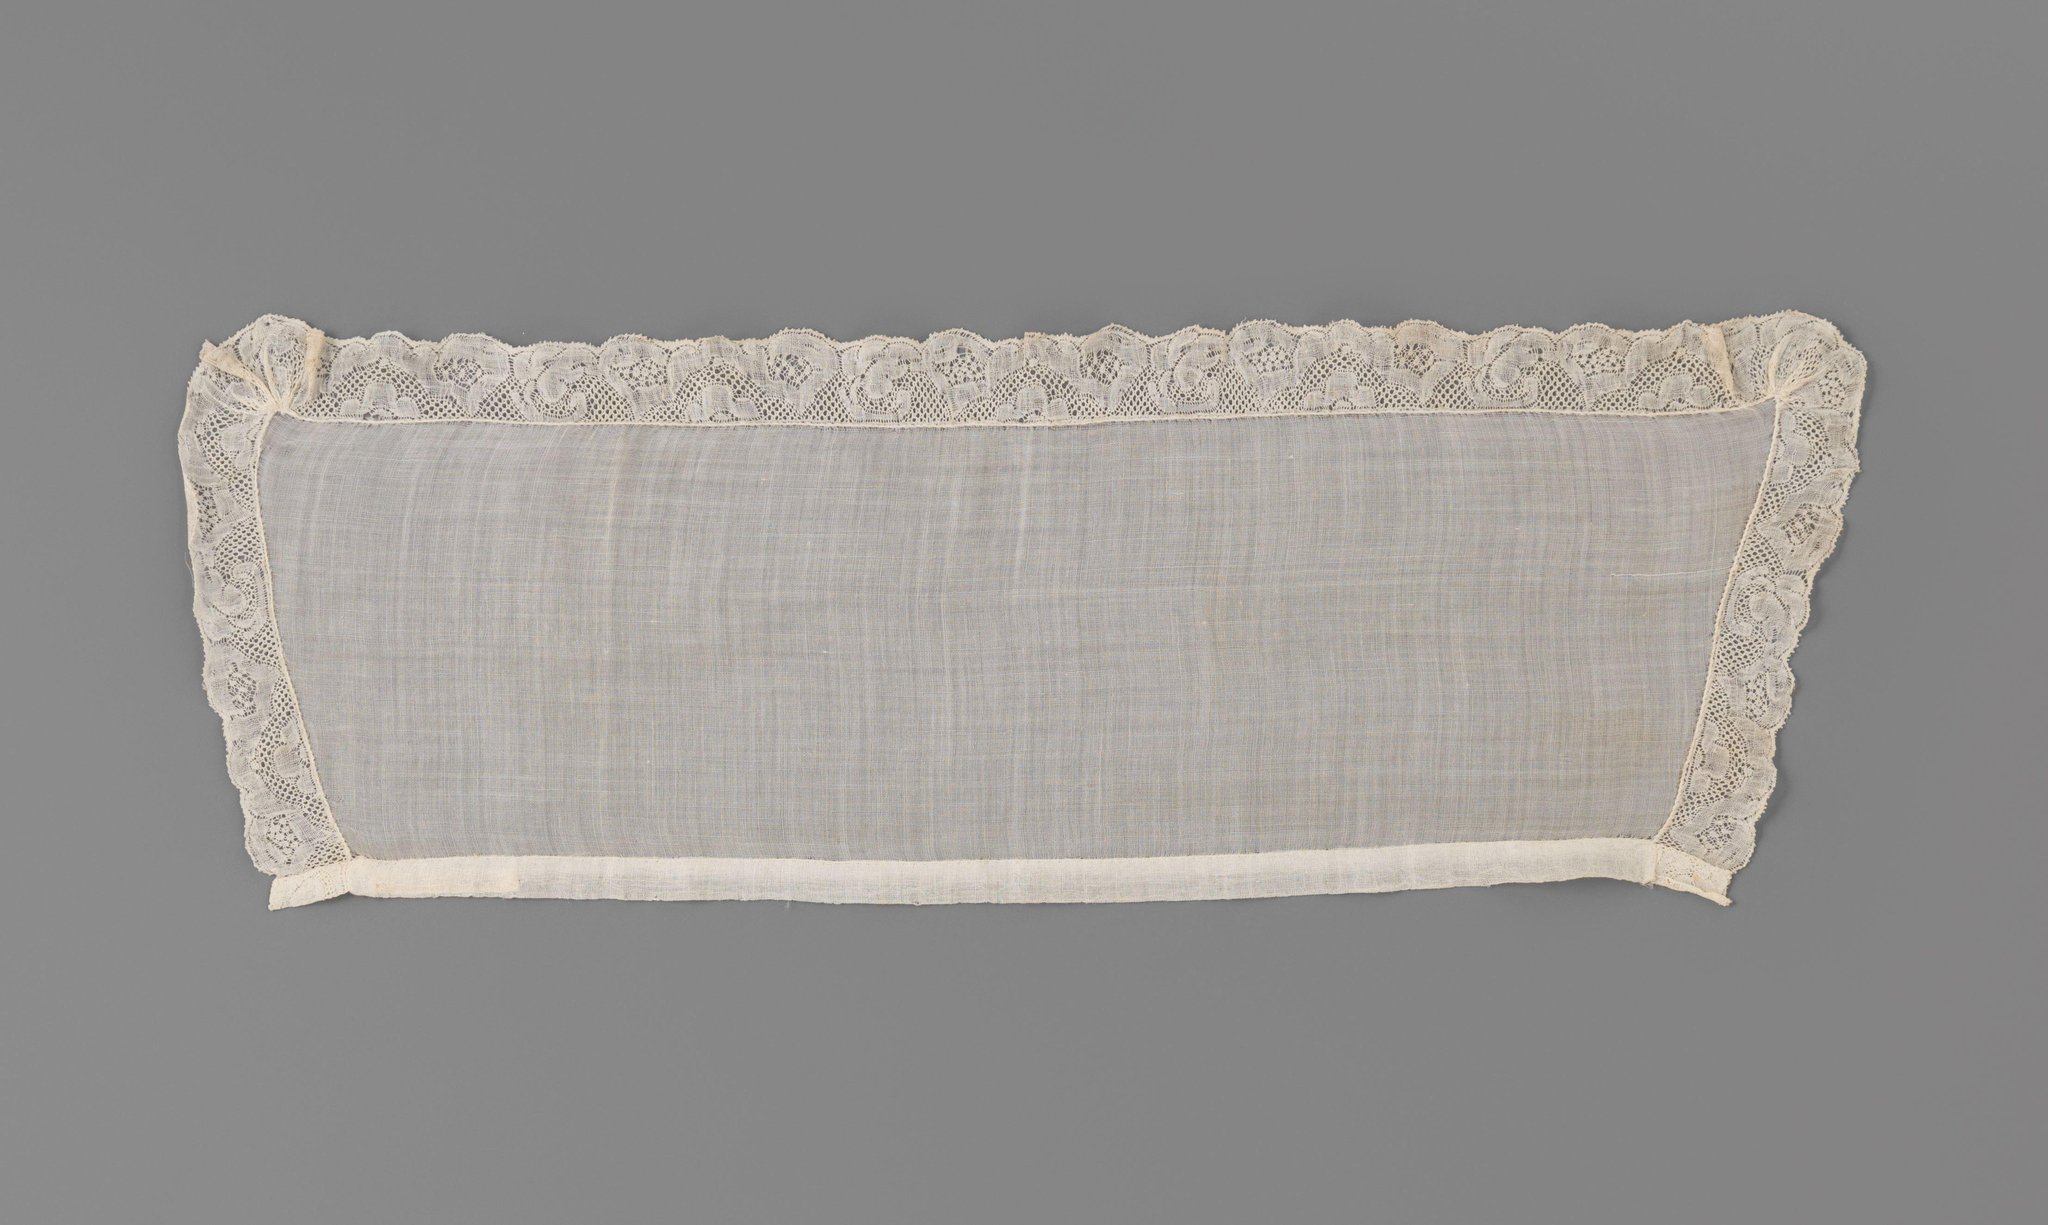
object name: strip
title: Kraag van linnenbatist met glad aangezette strook kloskant met roosjes en schulpenrand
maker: Anonymous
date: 1750-1799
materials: linen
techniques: lace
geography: binche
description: Kraag van linnenbatist met een glad aangezette strook naturelkleurige kloskant, Binche-kant. De kraag heeft een rechthoekig model. De strook heeft een patroon met roosjes en een schulpenrand. De motieven zijn met elkaar verbonden door een traliegrond, een vijfgaatjesgrond.